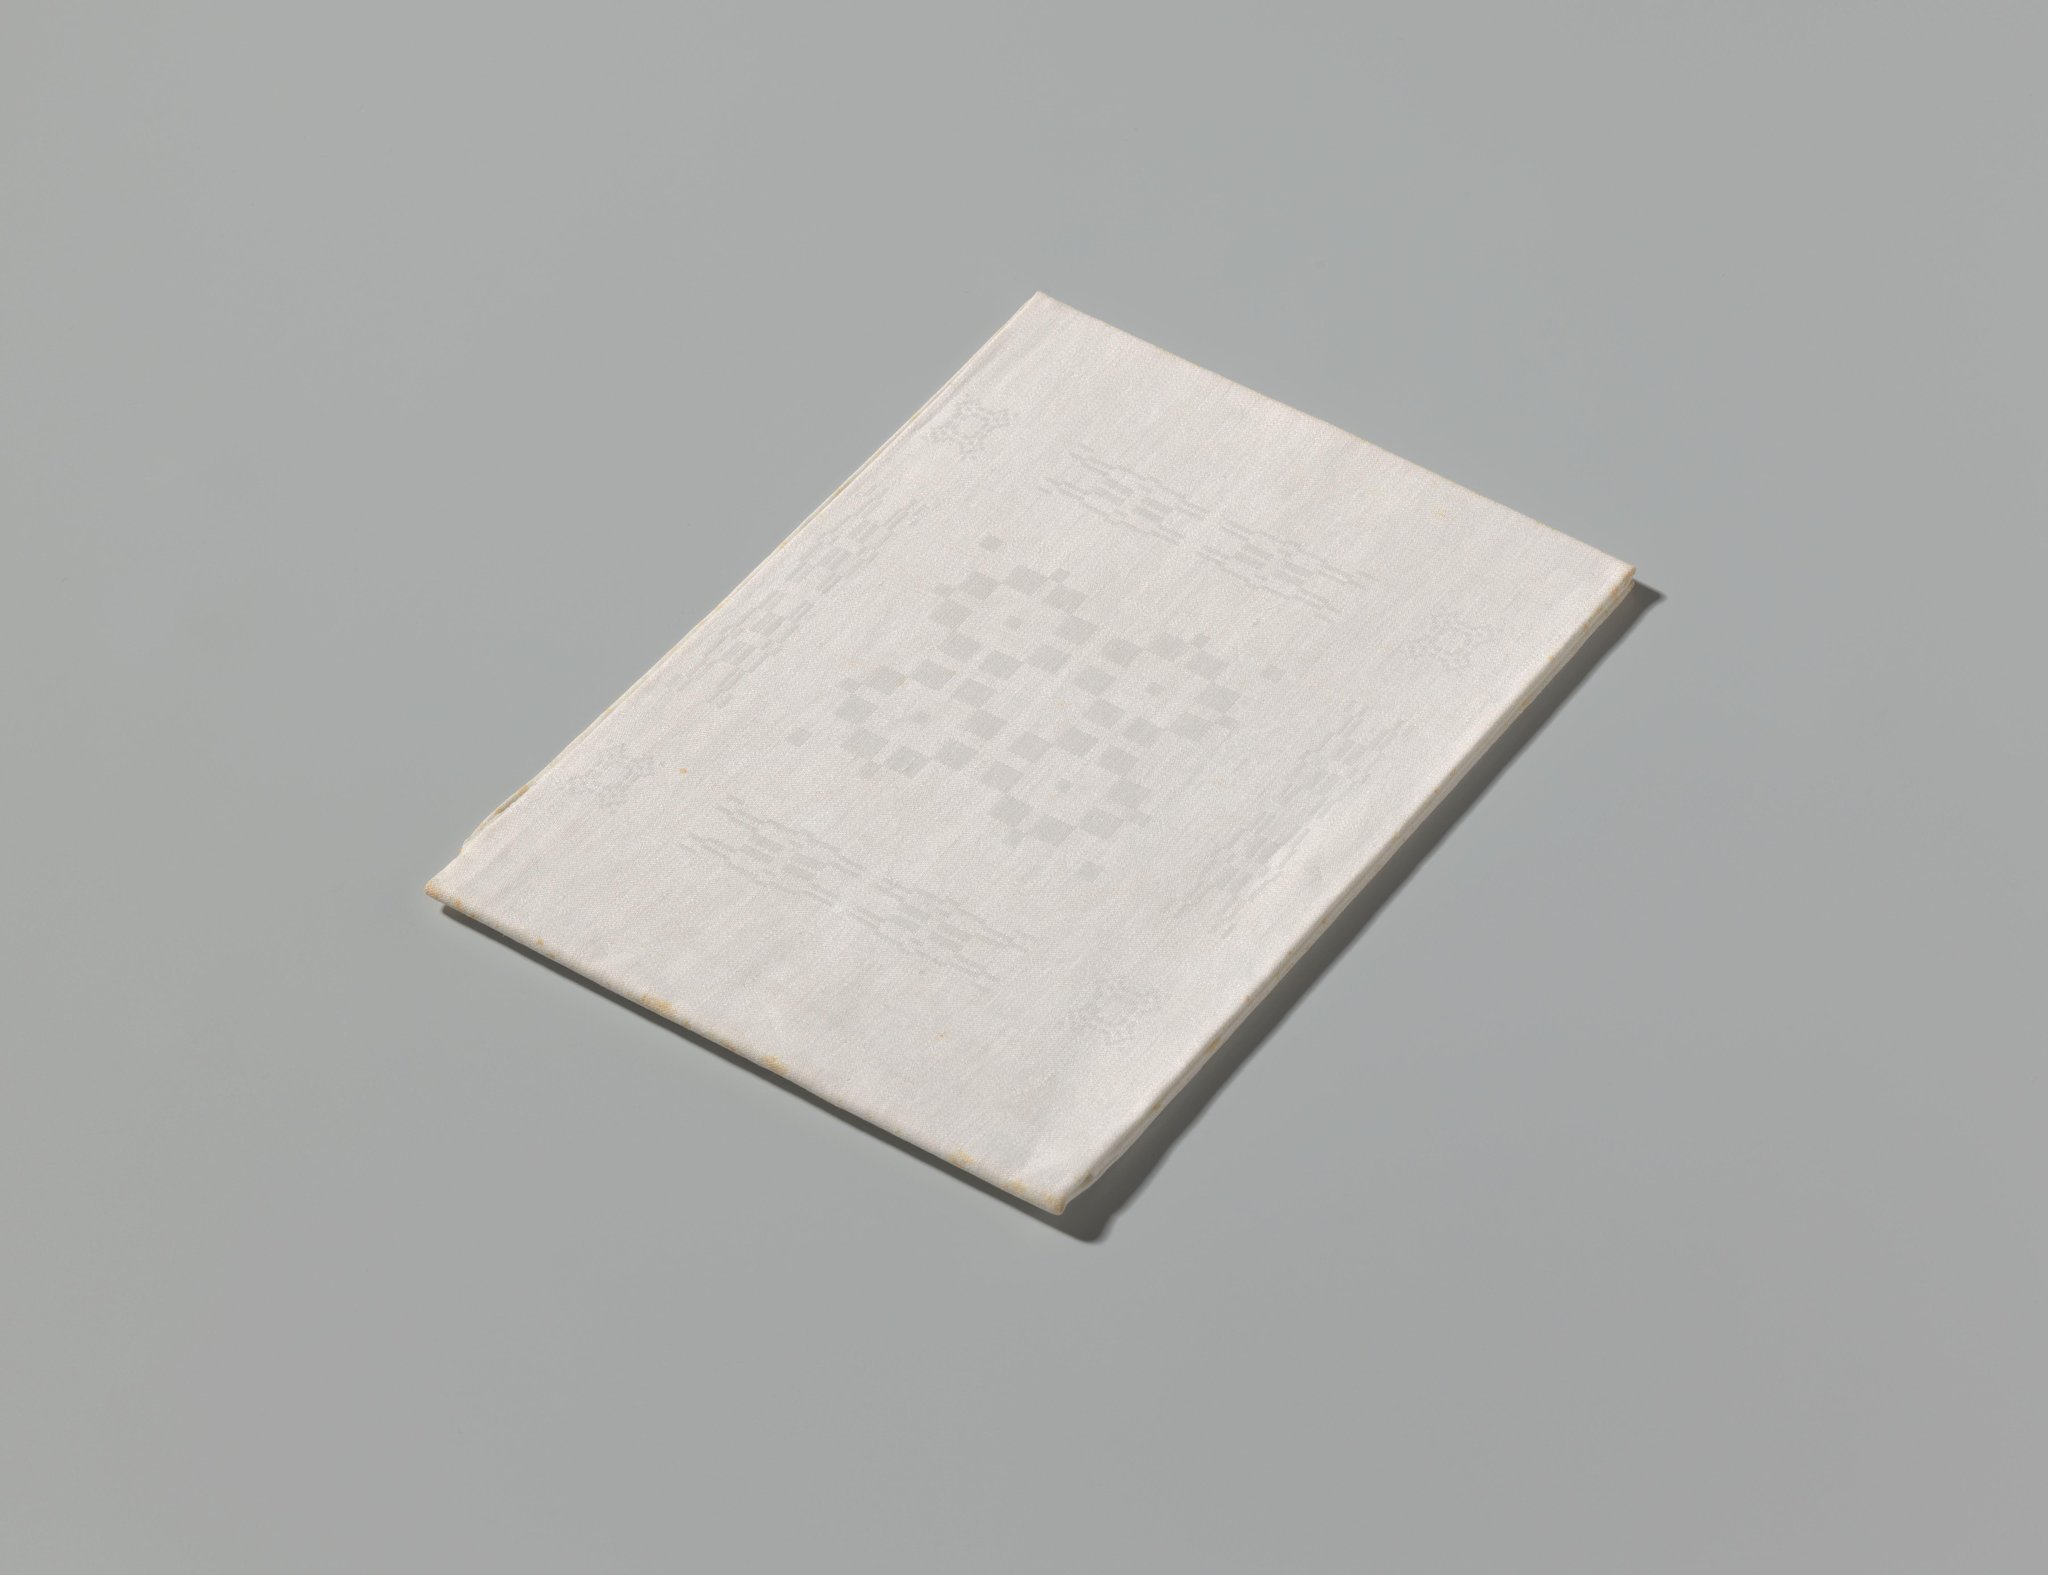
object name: napkin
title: Servet van pellendamast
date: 1800-1900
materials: linen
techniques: cross stitching, weave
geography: north brabant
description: Servet van pellendamast. Het veld is door doorbroken gestreepte lijnen in vierkanten verdeeld, waarbinnen een geblokt patroon. De randen zijn doorbroken gestreept. Het servet is in rood gemerkt met een kruissteek: G100.